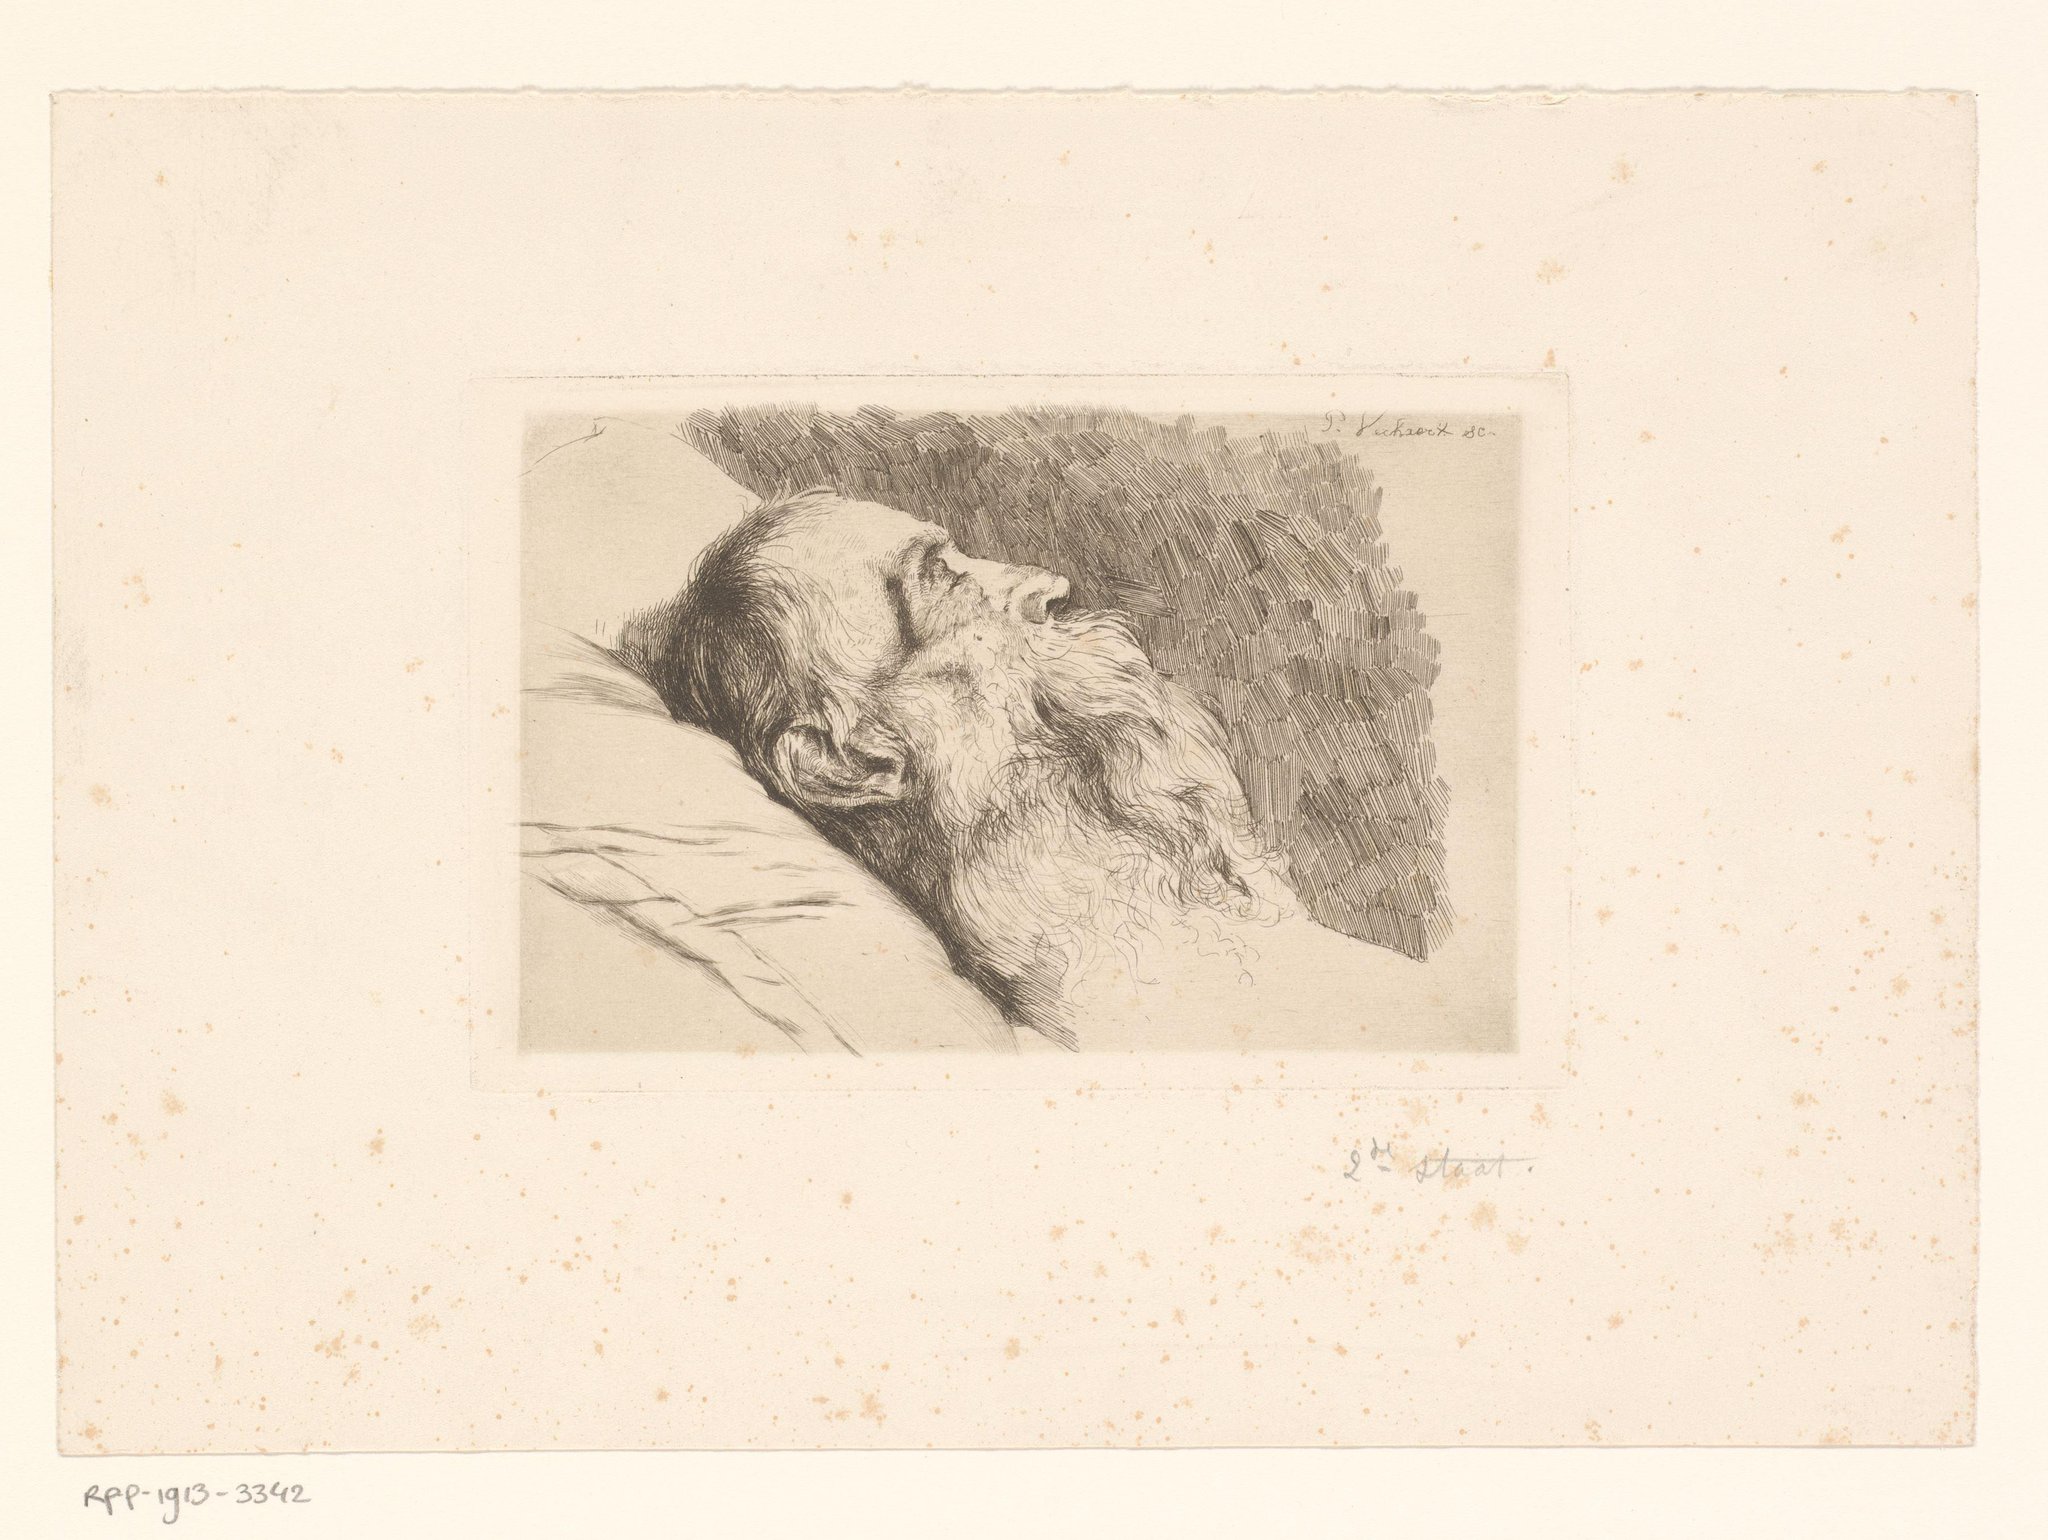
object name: print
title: Hendrik Conscience op zijn doodsbed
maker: piet verhaert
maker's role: print maker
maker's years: 1852-1908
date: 1883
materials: paper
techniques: etching, intaglio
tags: antwerp, deathbed, historical persons, beard, lying in state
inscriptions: inscription: ‘2de staat’, collector's mark: Lugt 2228